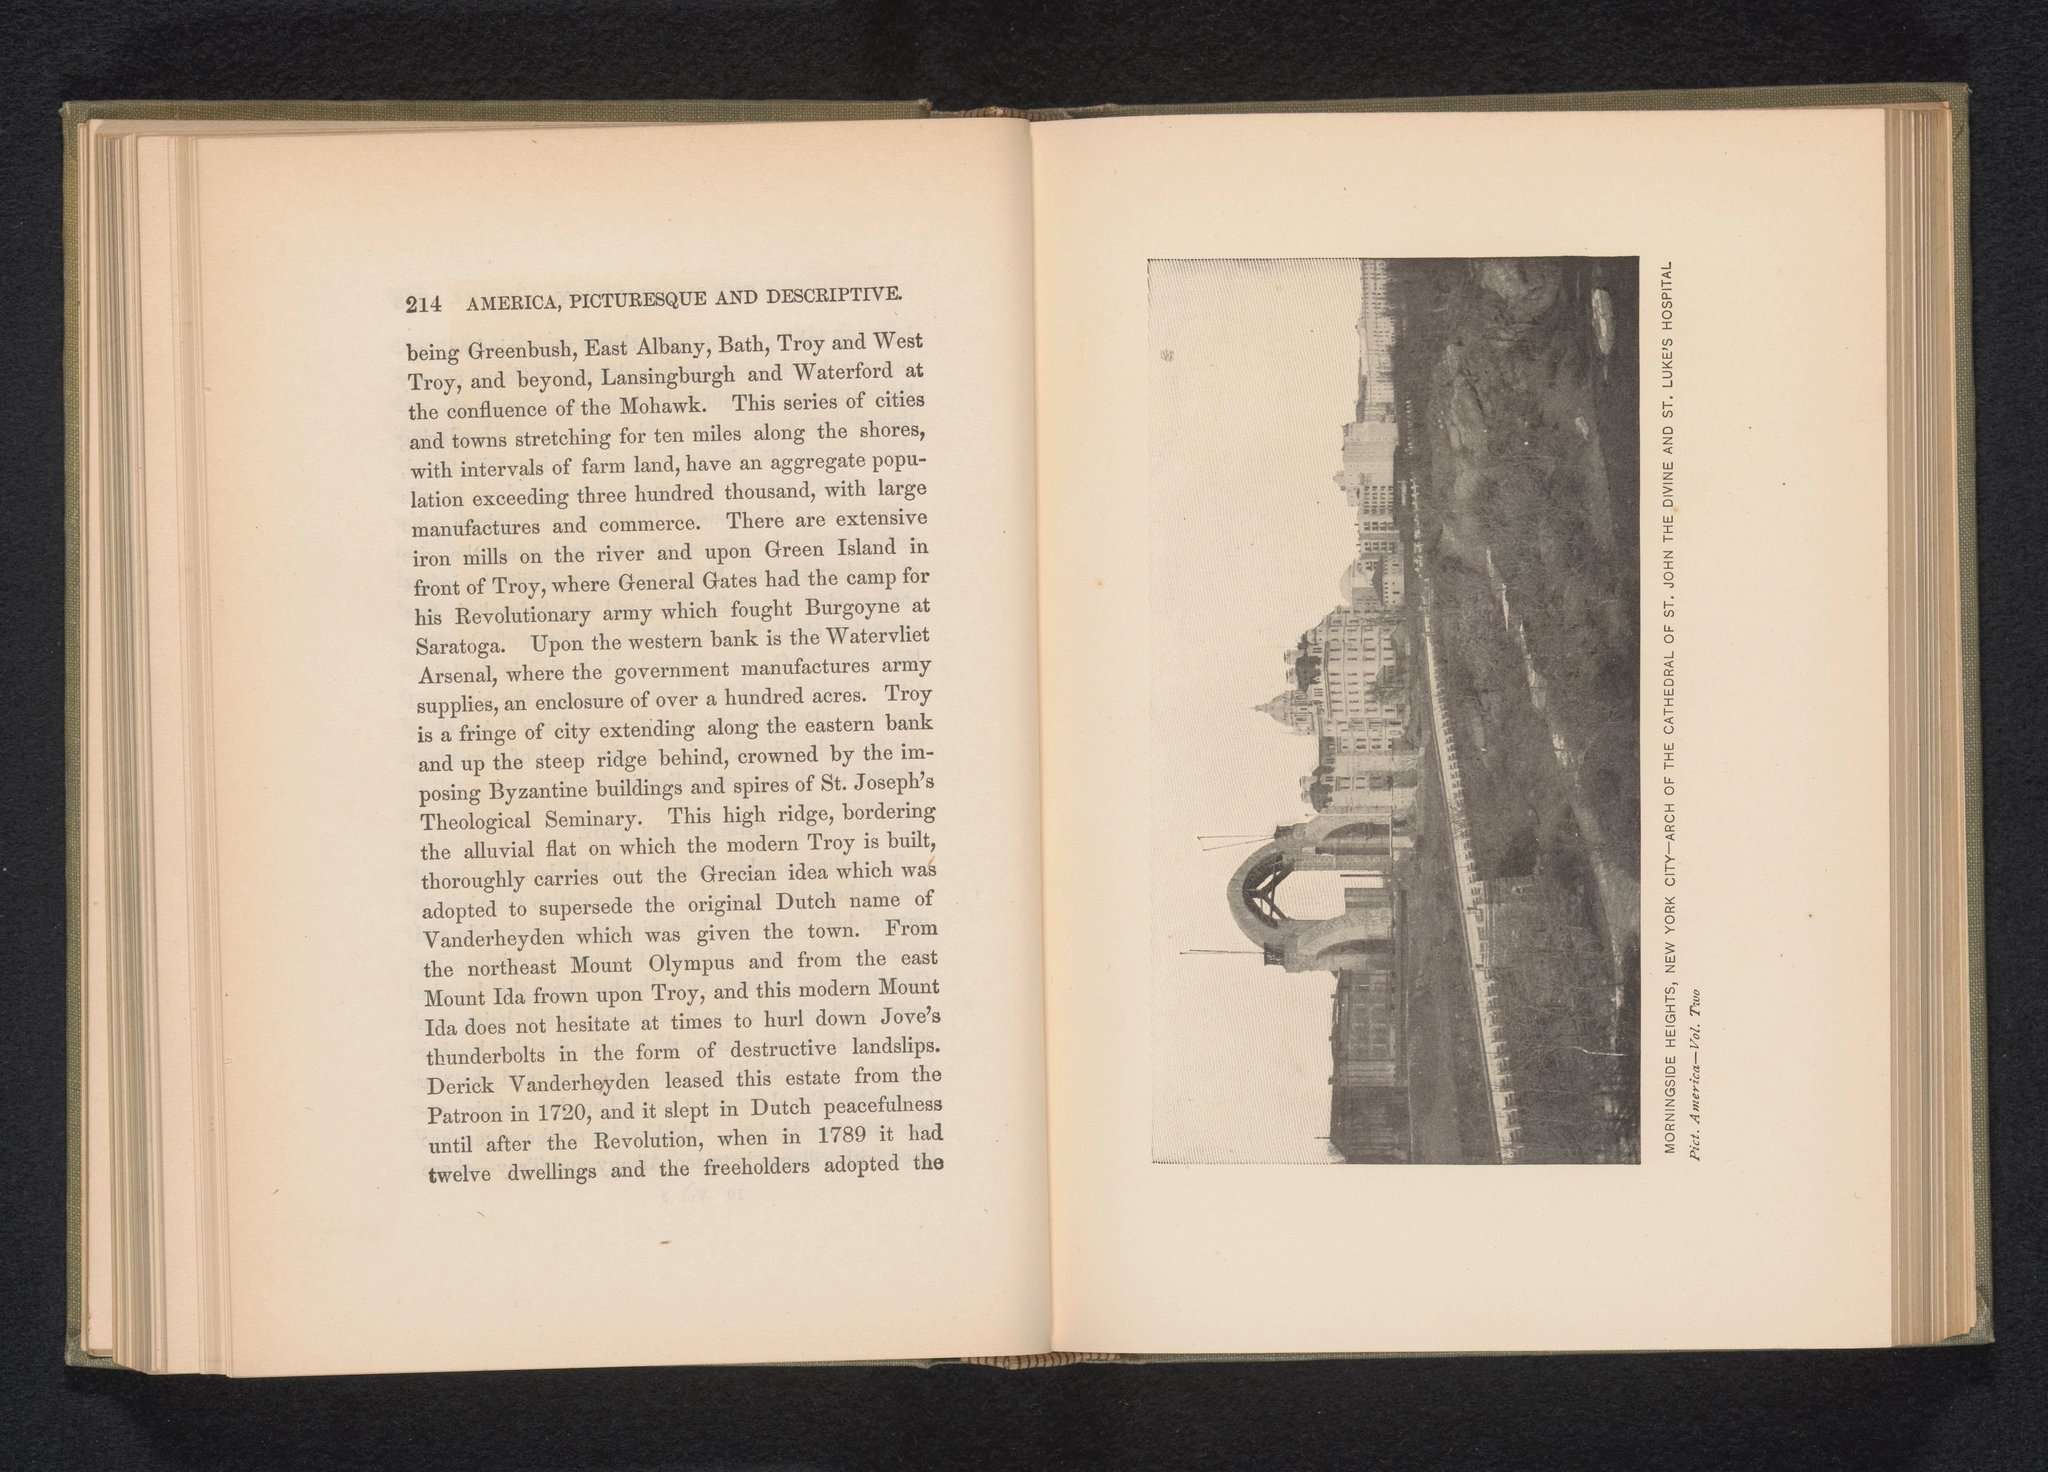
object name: photomechanical print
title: Morningside Heights, New York City-Arch of the Cathedral of St. John the divine and St. Luke's Hospital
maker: Anonymous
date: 1892-1900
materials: paper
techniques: autotype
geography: morningside heights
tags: city-view, and landscape with man-made constructions, public gardens, park